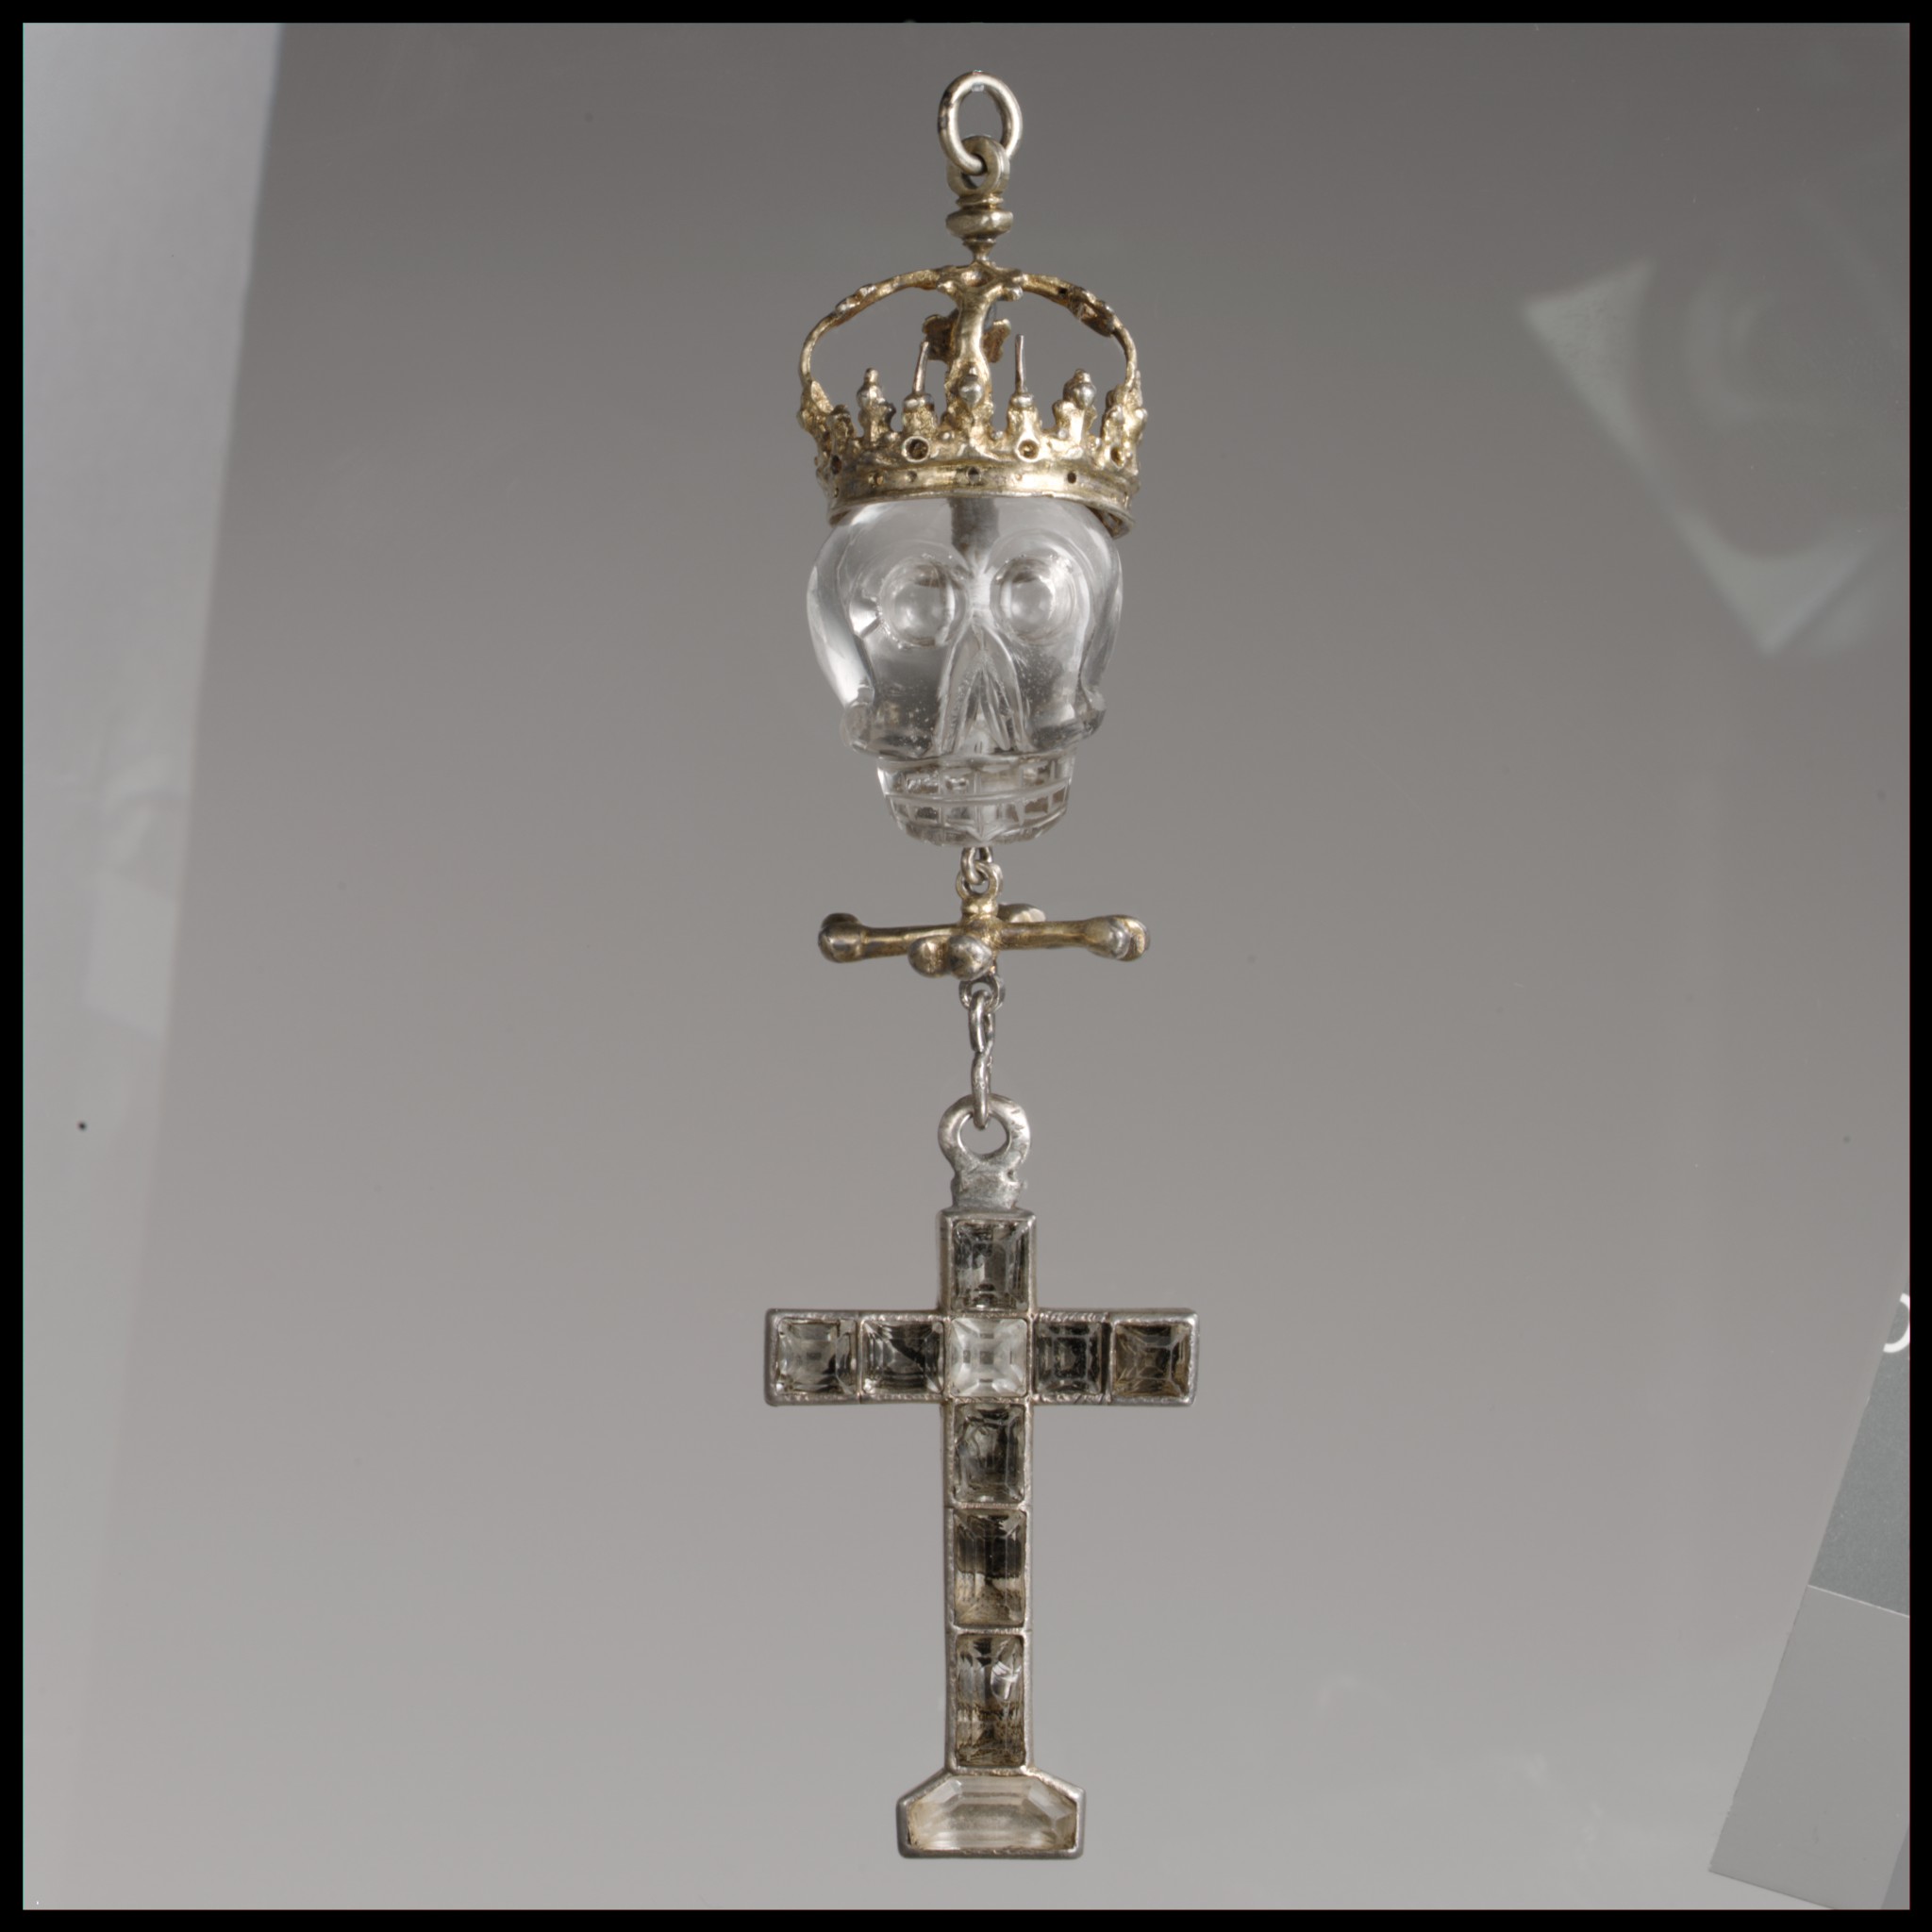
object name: rosary pendant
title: Pendant of a rosary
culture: mexican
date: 1501-1600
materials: quartz, silver gilt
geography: belgium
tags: skulls,cross,crowns